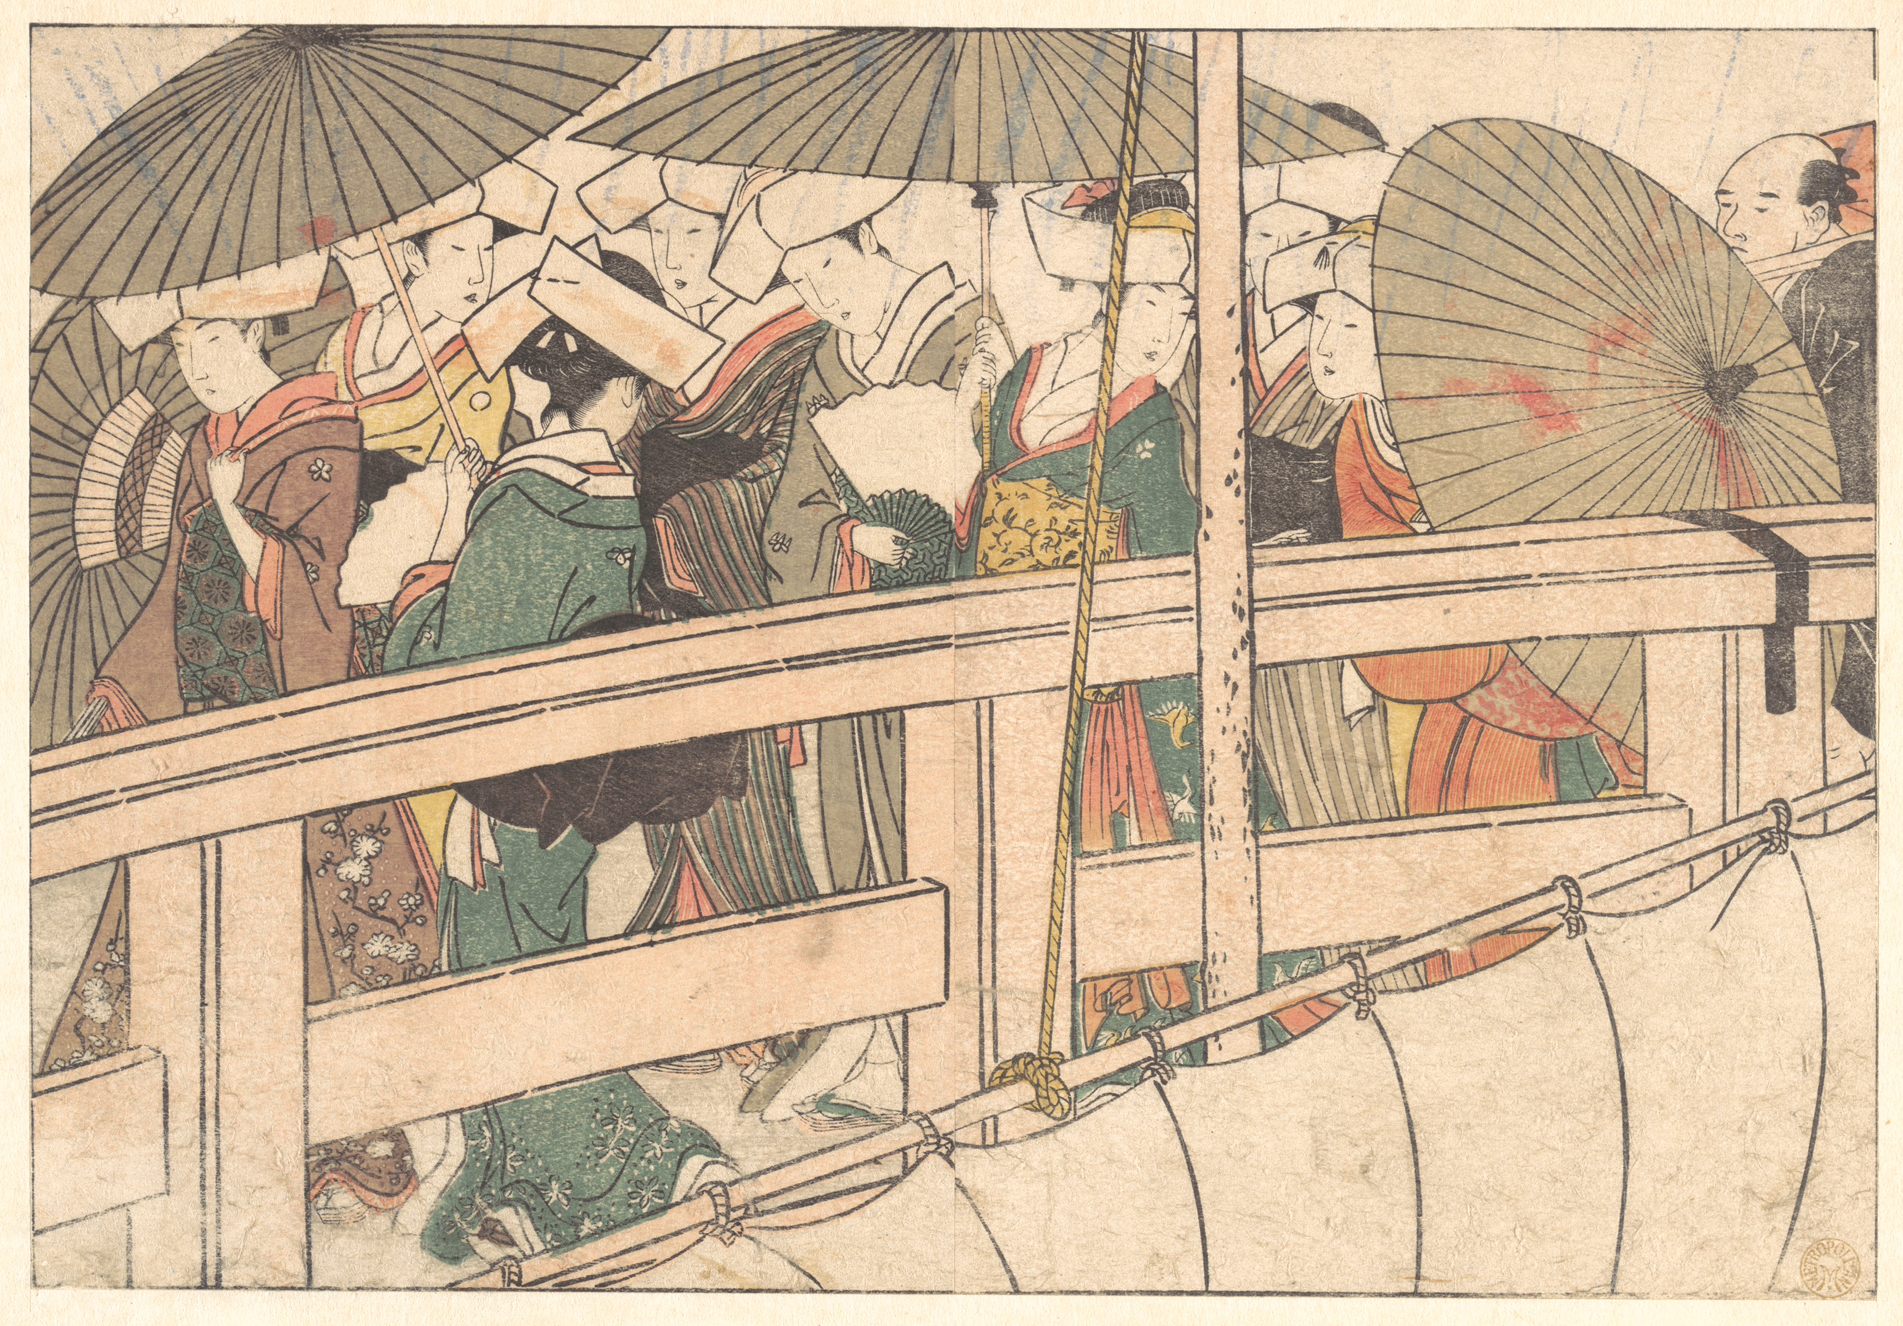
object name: woodblock print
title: Women on a Bridge, from the illustrated book Flowers of the Four Seasons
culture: japanese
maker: kitagawa utamaro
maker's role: artist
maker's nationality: japanese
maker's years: 1754-1806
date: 1801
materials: ink, paper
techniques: woodblock print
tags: bridges,men,women,crowd